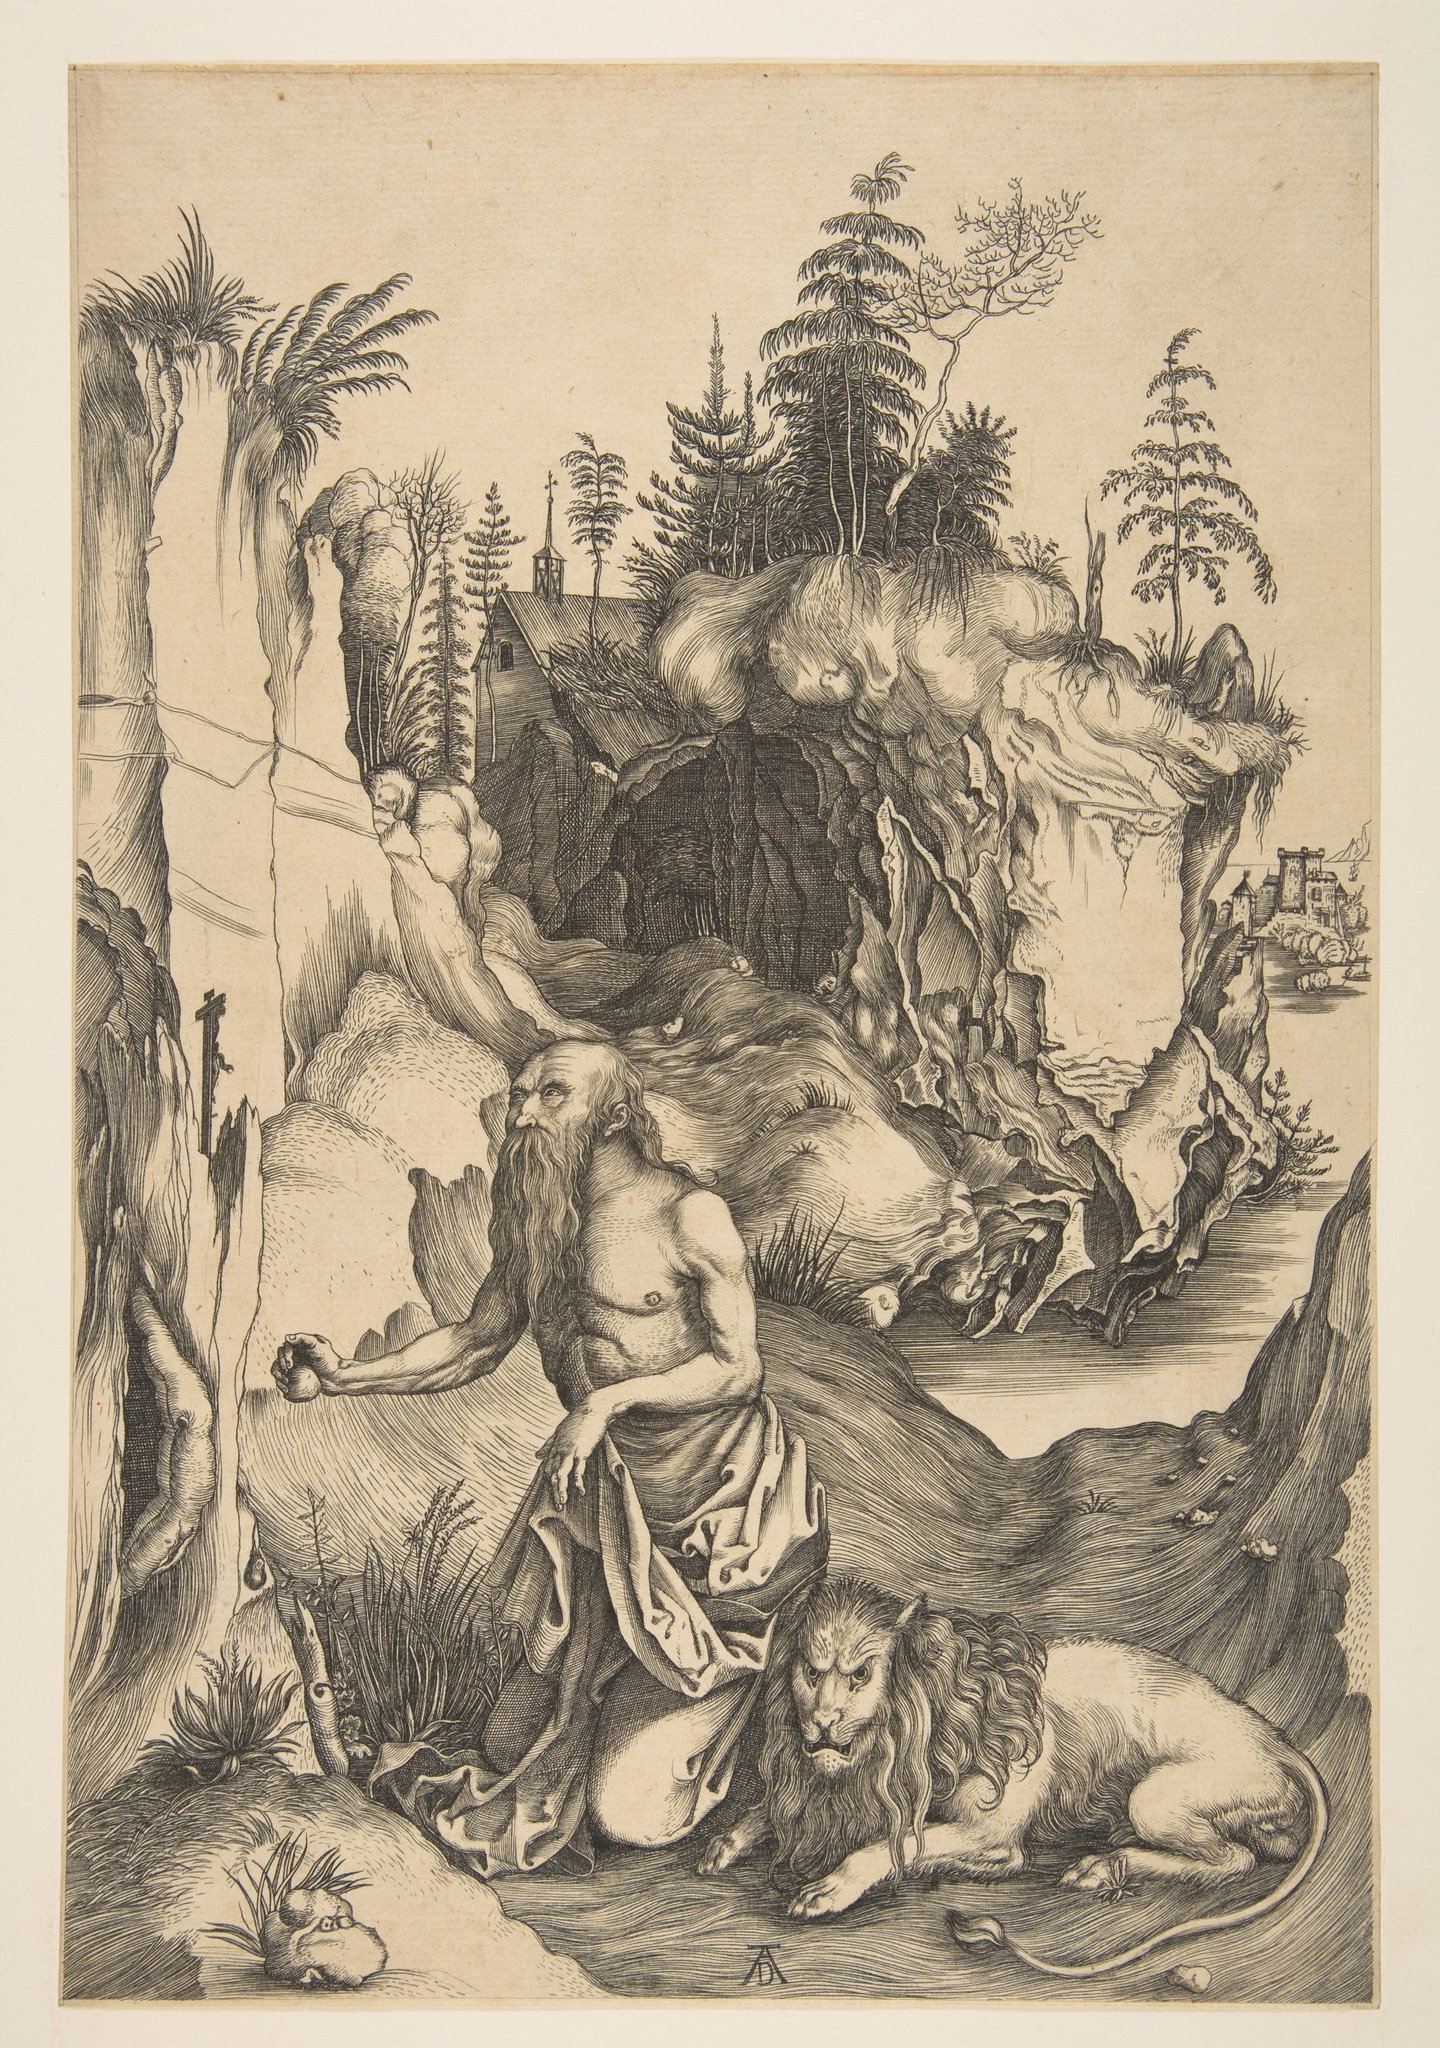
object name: print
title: Saint Jerome Penitent in the Wilderness (copy)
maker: albrecht dürer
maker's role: artist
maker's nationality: german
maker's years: 1471-1528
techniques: engraving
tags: lions,saint jerome